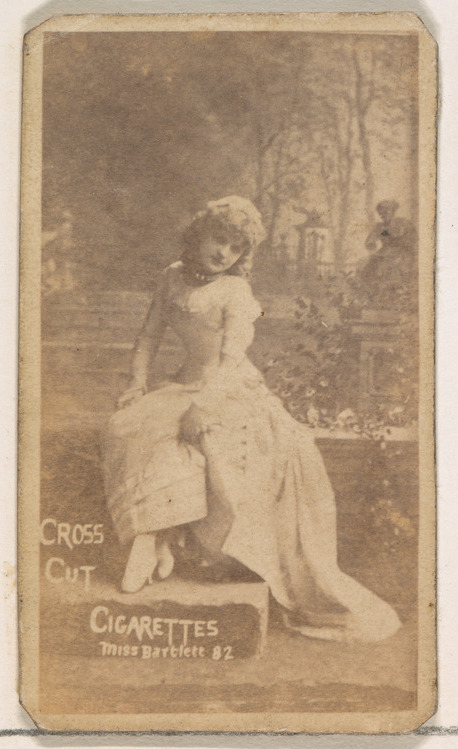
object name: print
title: Card Number 82, Miss Bartlett, from the Actors and Actresses series (N145-1) issued by Duke Sons & Co. to promote Cross Cut Cigarettes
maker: w. duke, sons & co.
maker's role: publisher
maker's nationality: american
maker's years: 1870-1920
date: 1880-1889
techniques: albumen silver print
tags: portraits,women,actresses